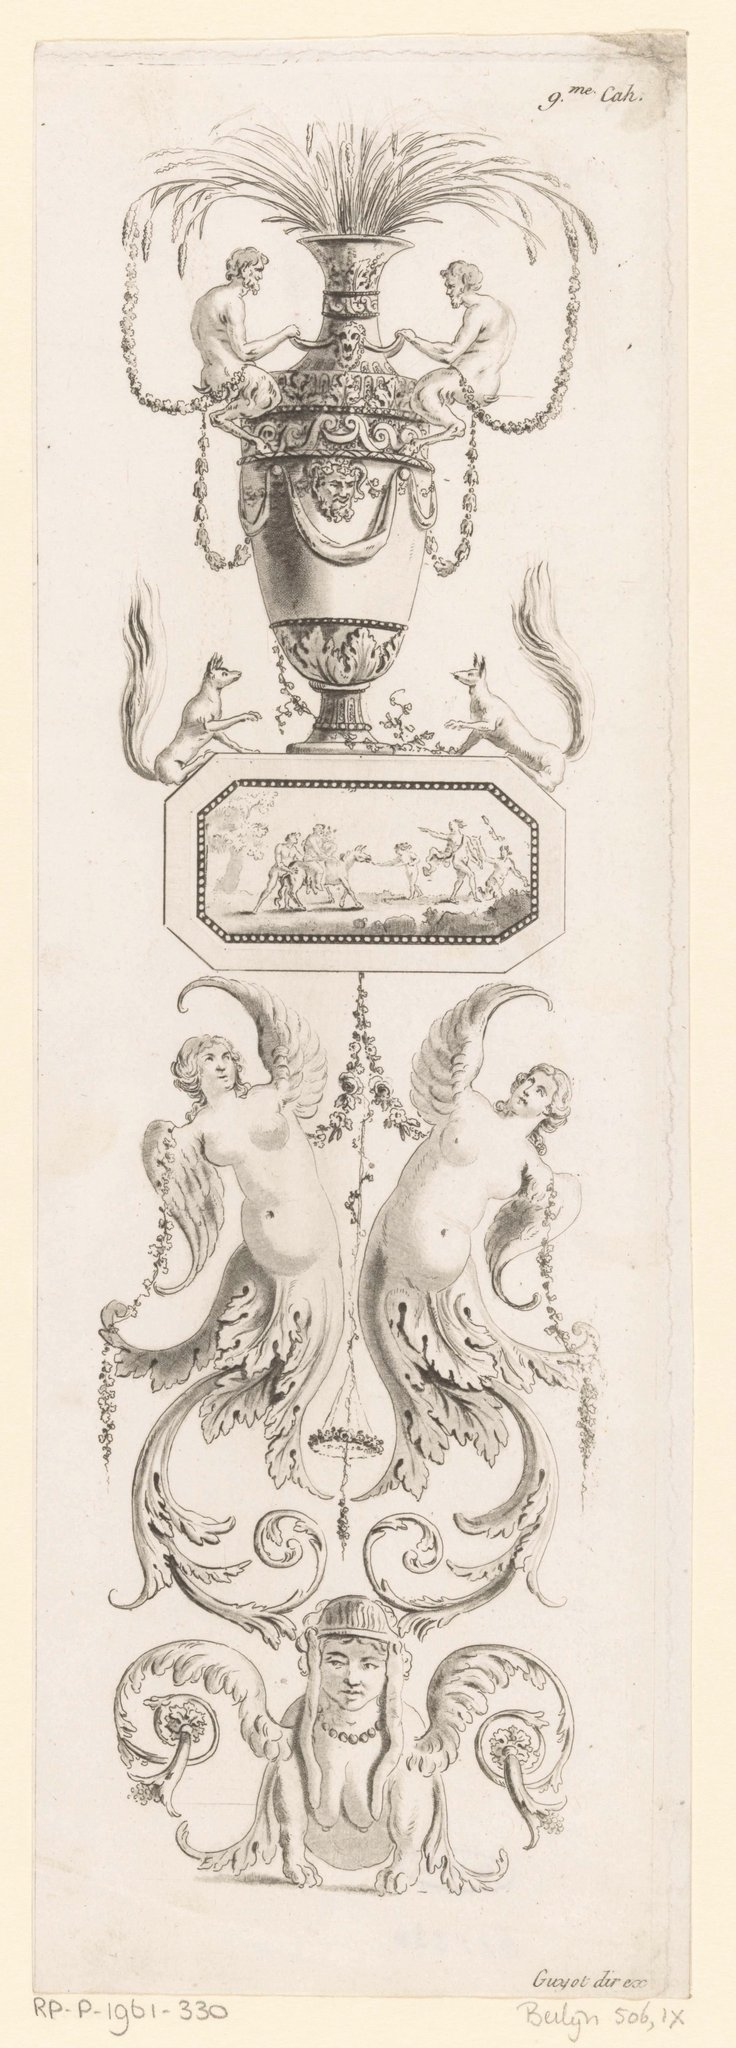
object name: print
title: 9me Cahier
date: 1788-1810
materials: paper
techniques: aquatint, etching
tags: ornament ~ arabesque, vase ~ ornament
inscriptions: collector's mark: Lugt 2228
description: Arabesken met een vaas met saters, eekhoorns, een tablet met figuren, twee vrouwelijke halffiguren met vleugels en een sfinx.